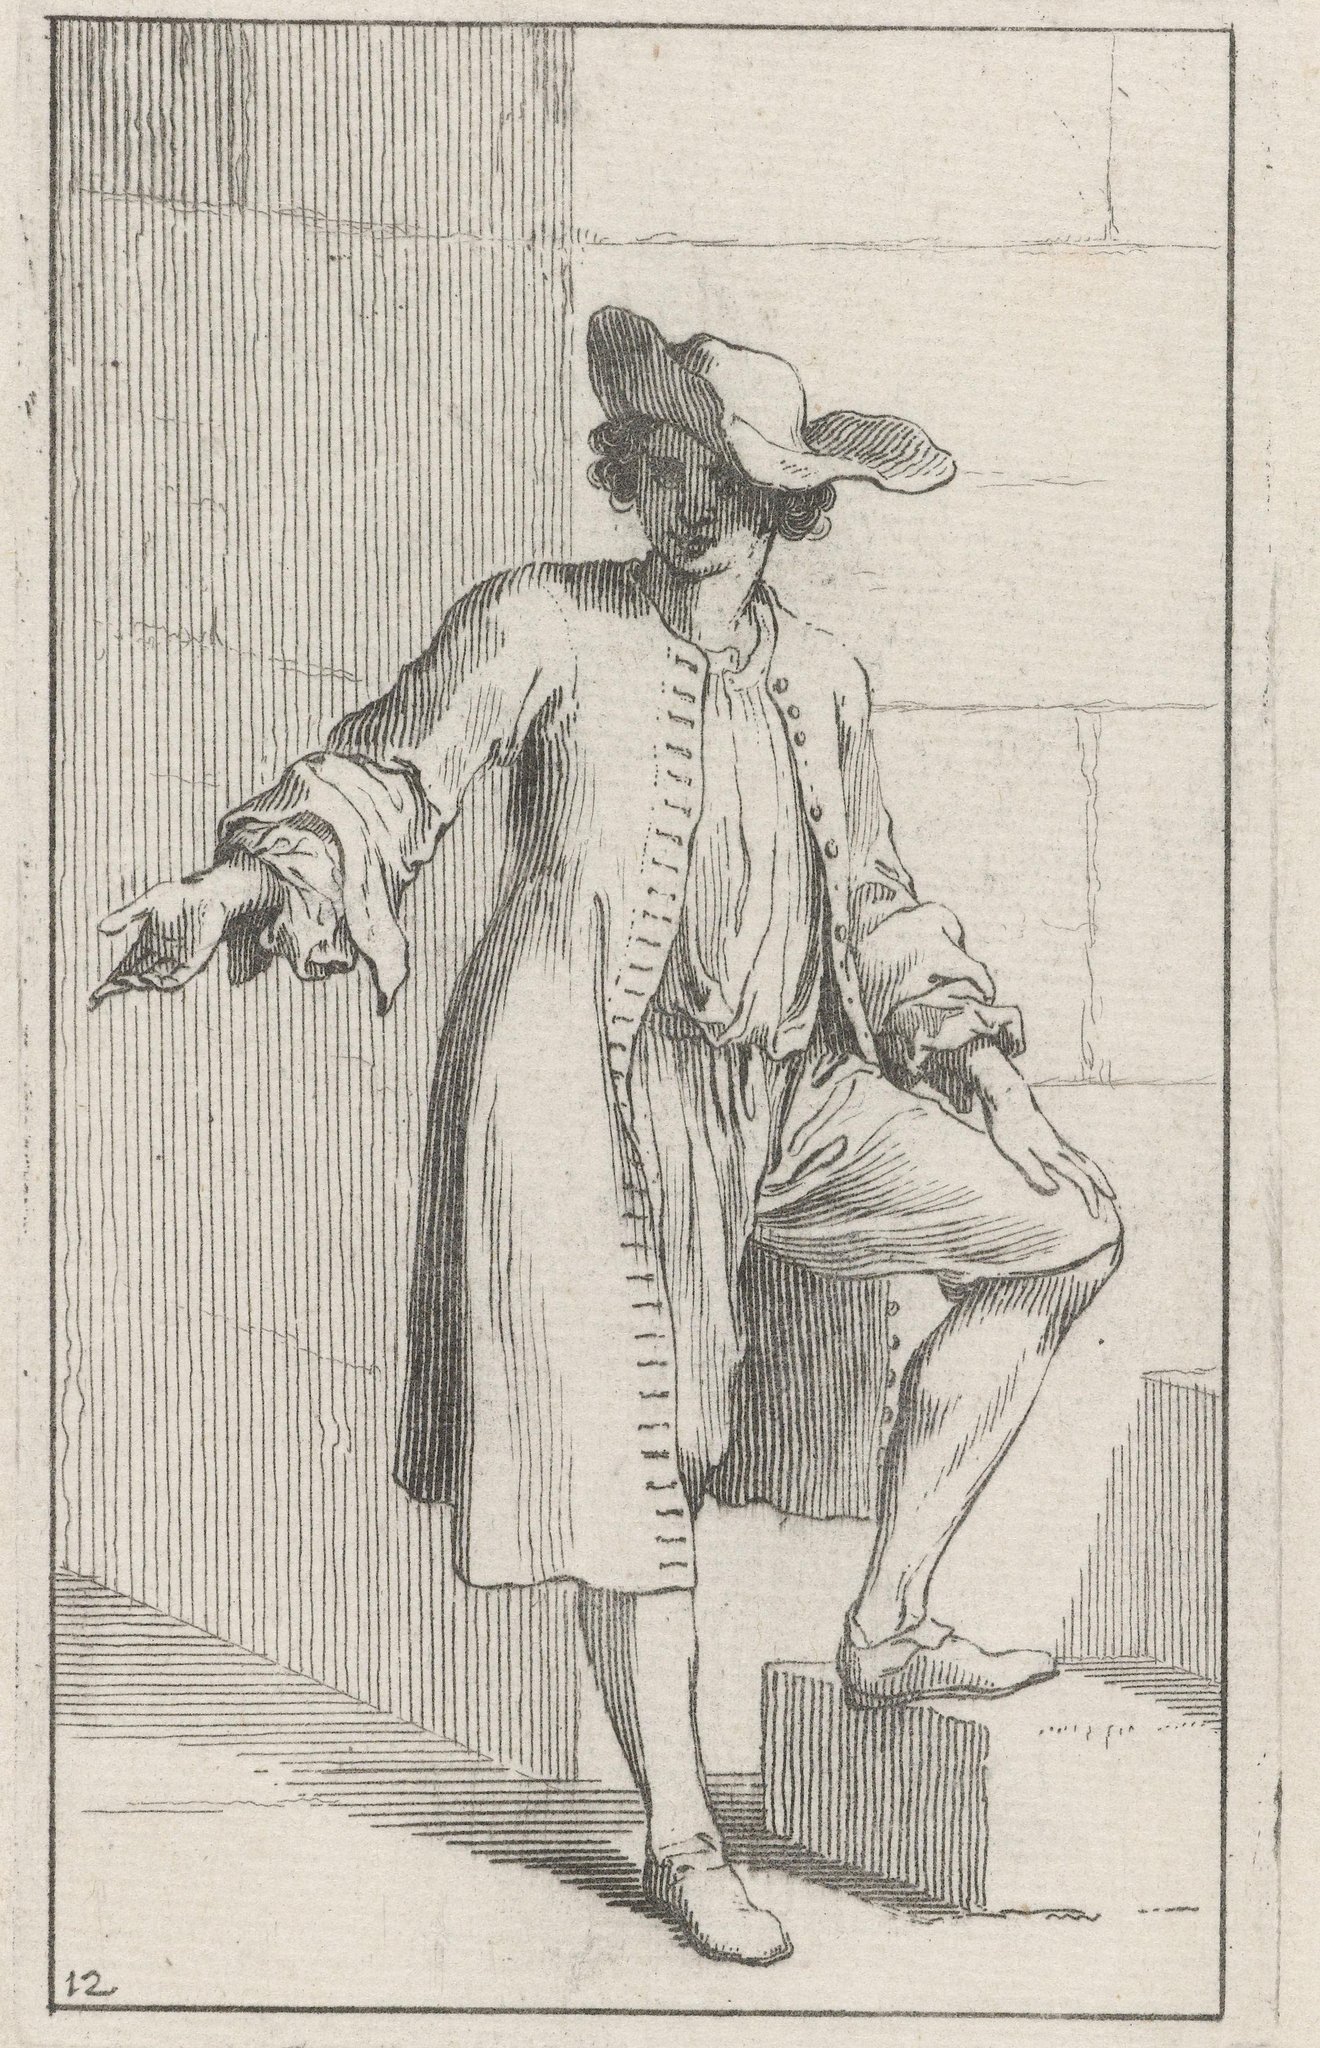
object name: print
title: Figures a la mode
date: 1685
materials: paper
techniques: etching